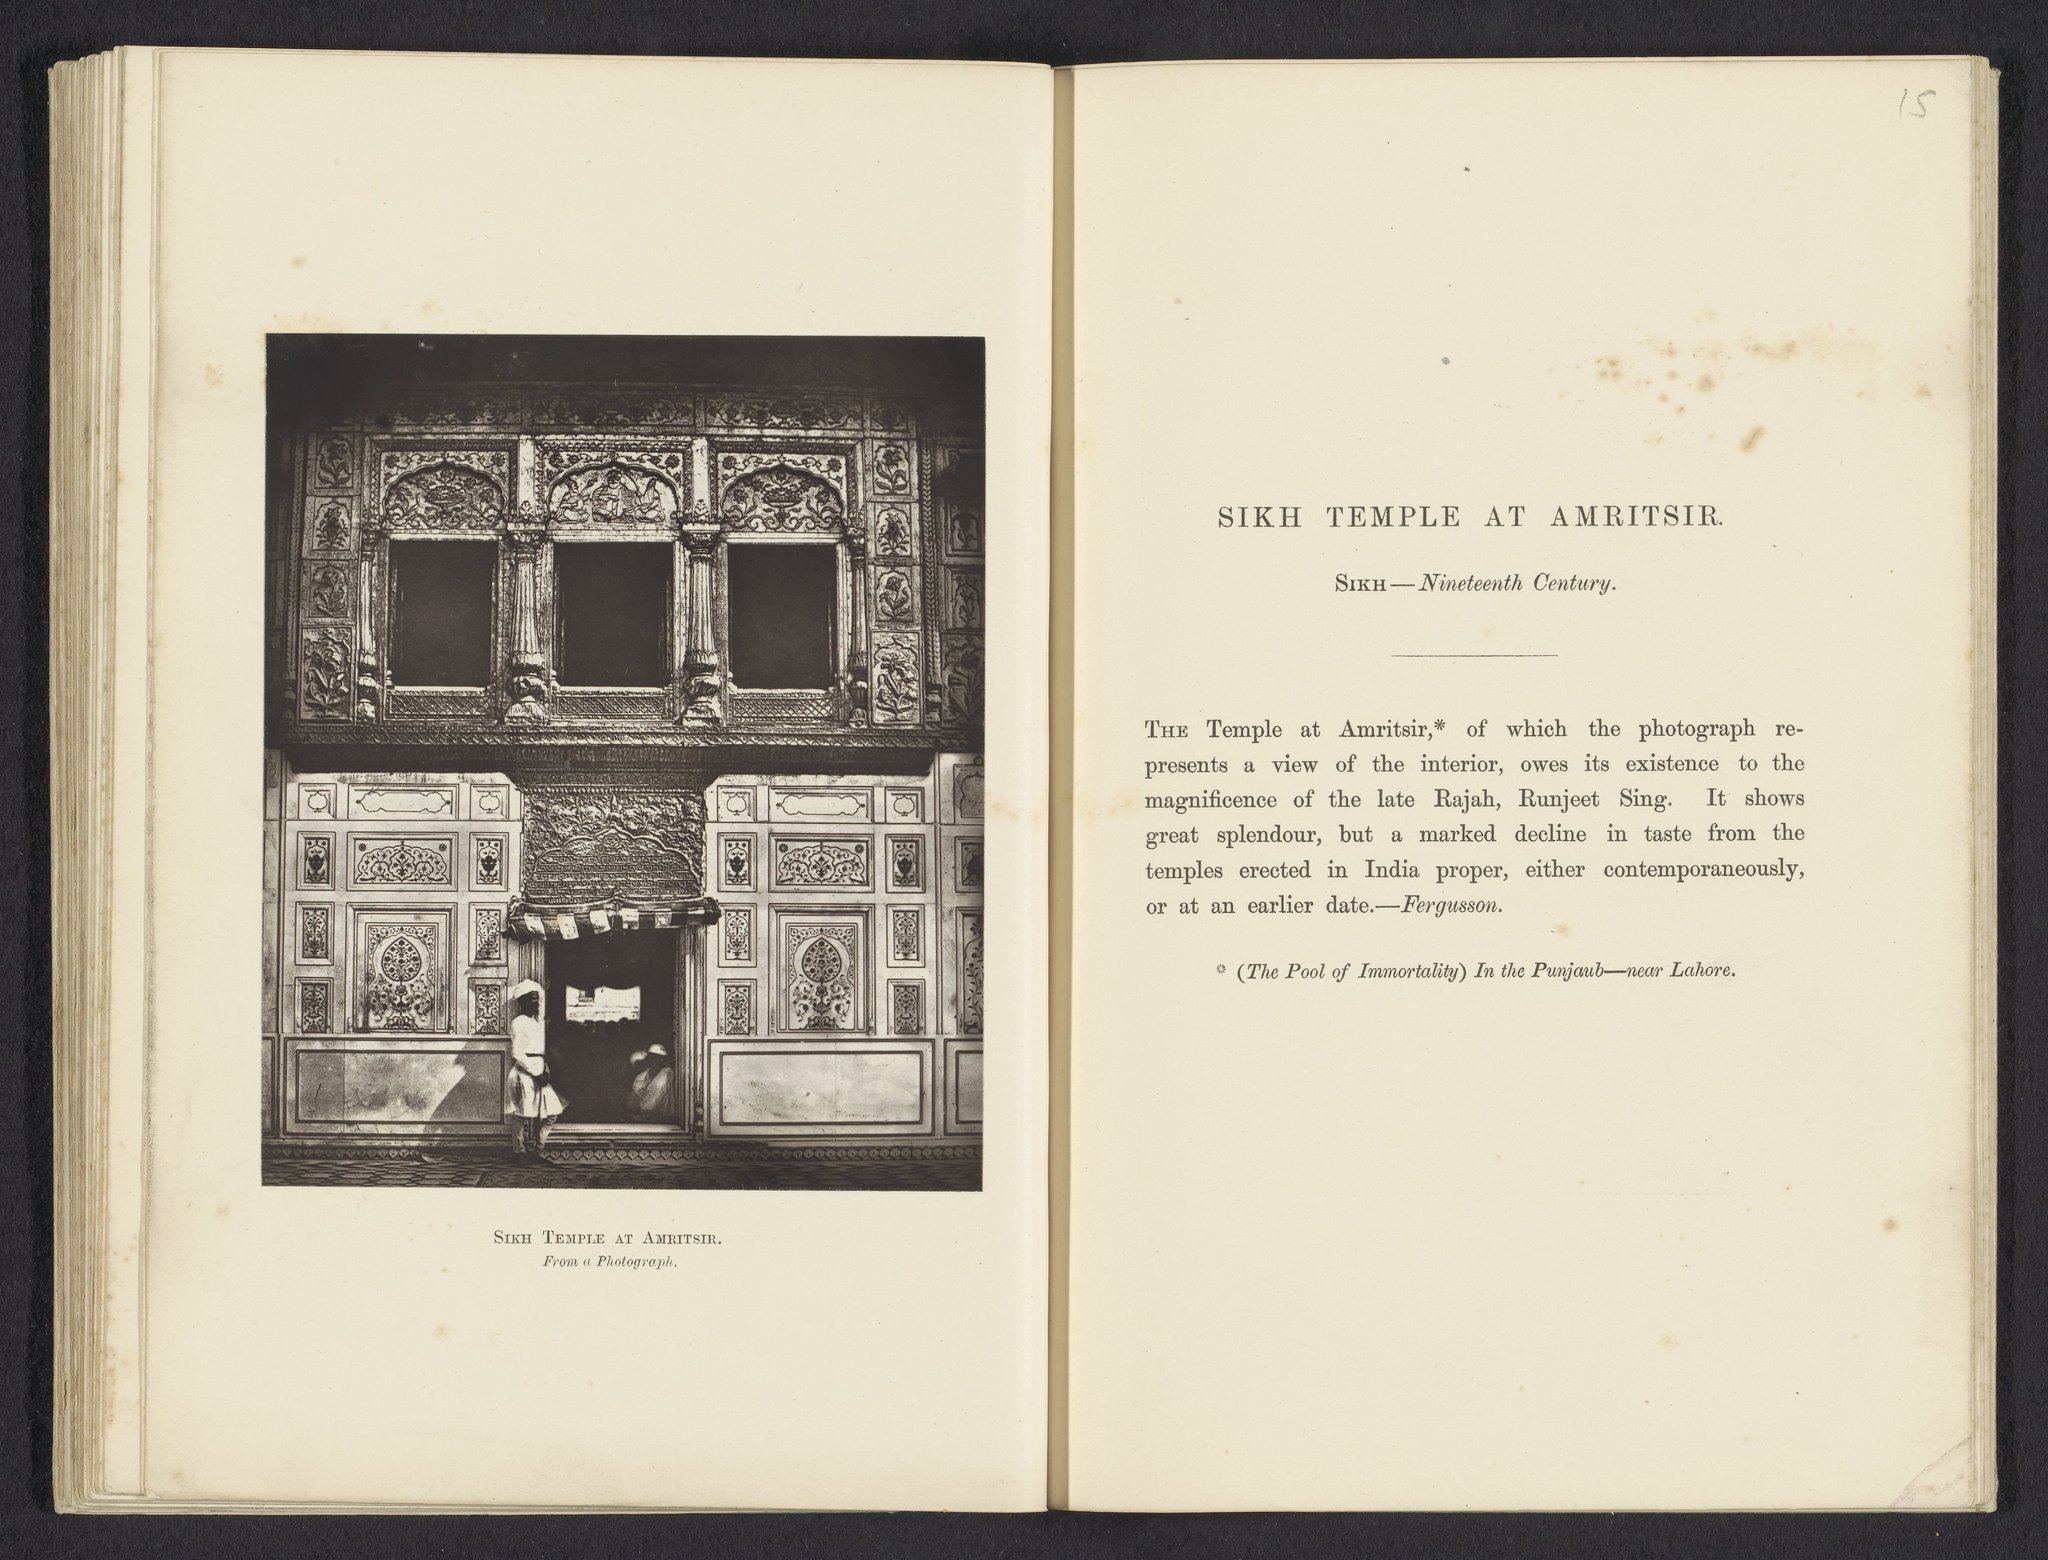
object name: photomechanical print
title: Interior of Harmandir Sahib or the Golden Temple at Amritsar, Punjab, India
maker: Anonymous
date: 1864-1869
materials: paper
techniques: woodburytype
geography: harmandir sahib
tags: temple, shrine ~ hinduism, buddhism, jainism, exterior ~ representation of a building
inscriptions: caption: ‘SIKH TEMPLE AT AMRITSIR./ From a Photograph.’